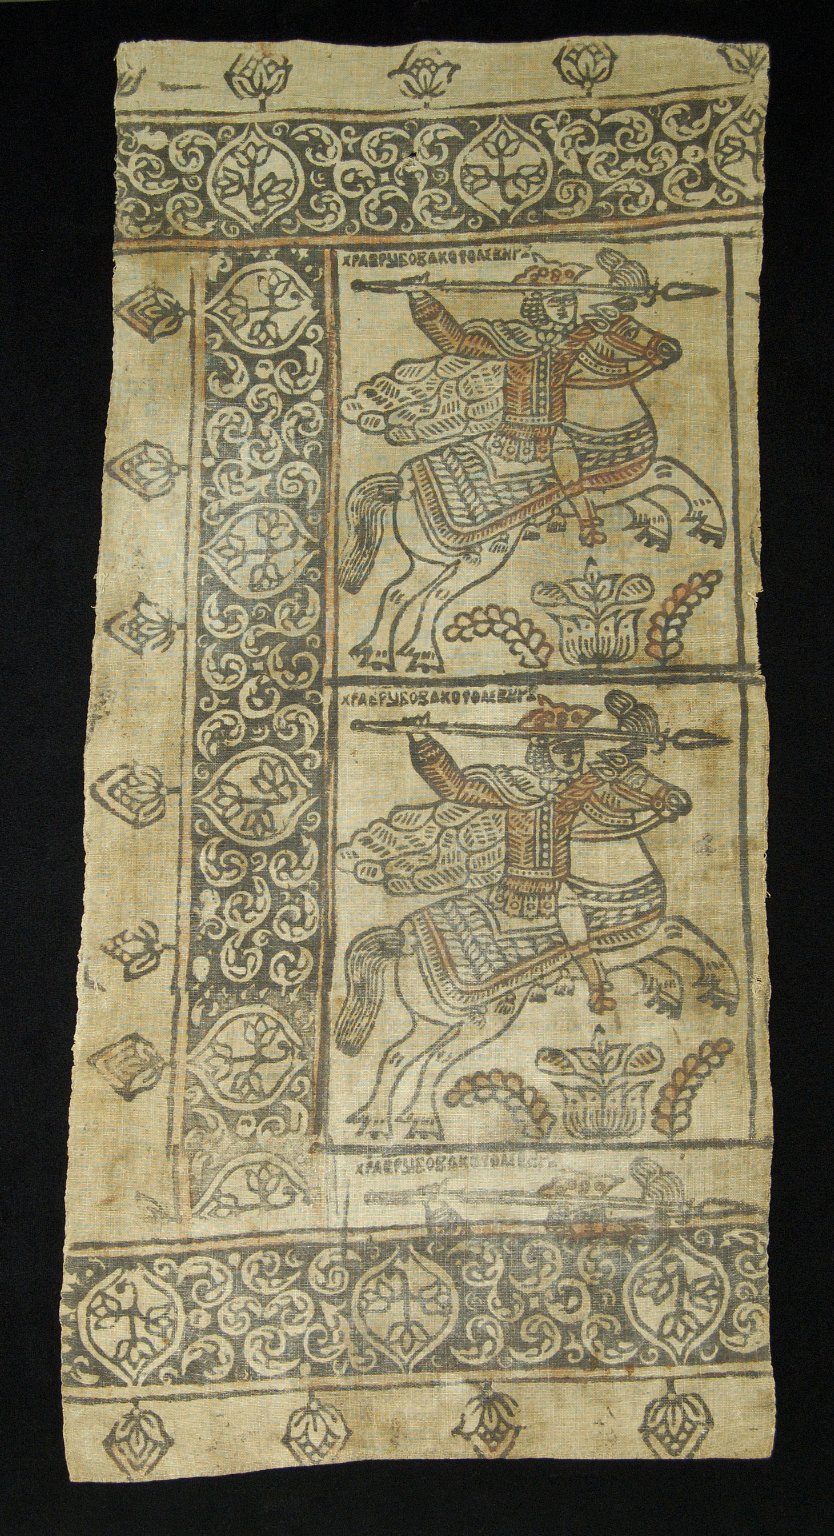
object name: fragment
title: Textile fragment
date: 1600-1799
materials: linen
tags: horses